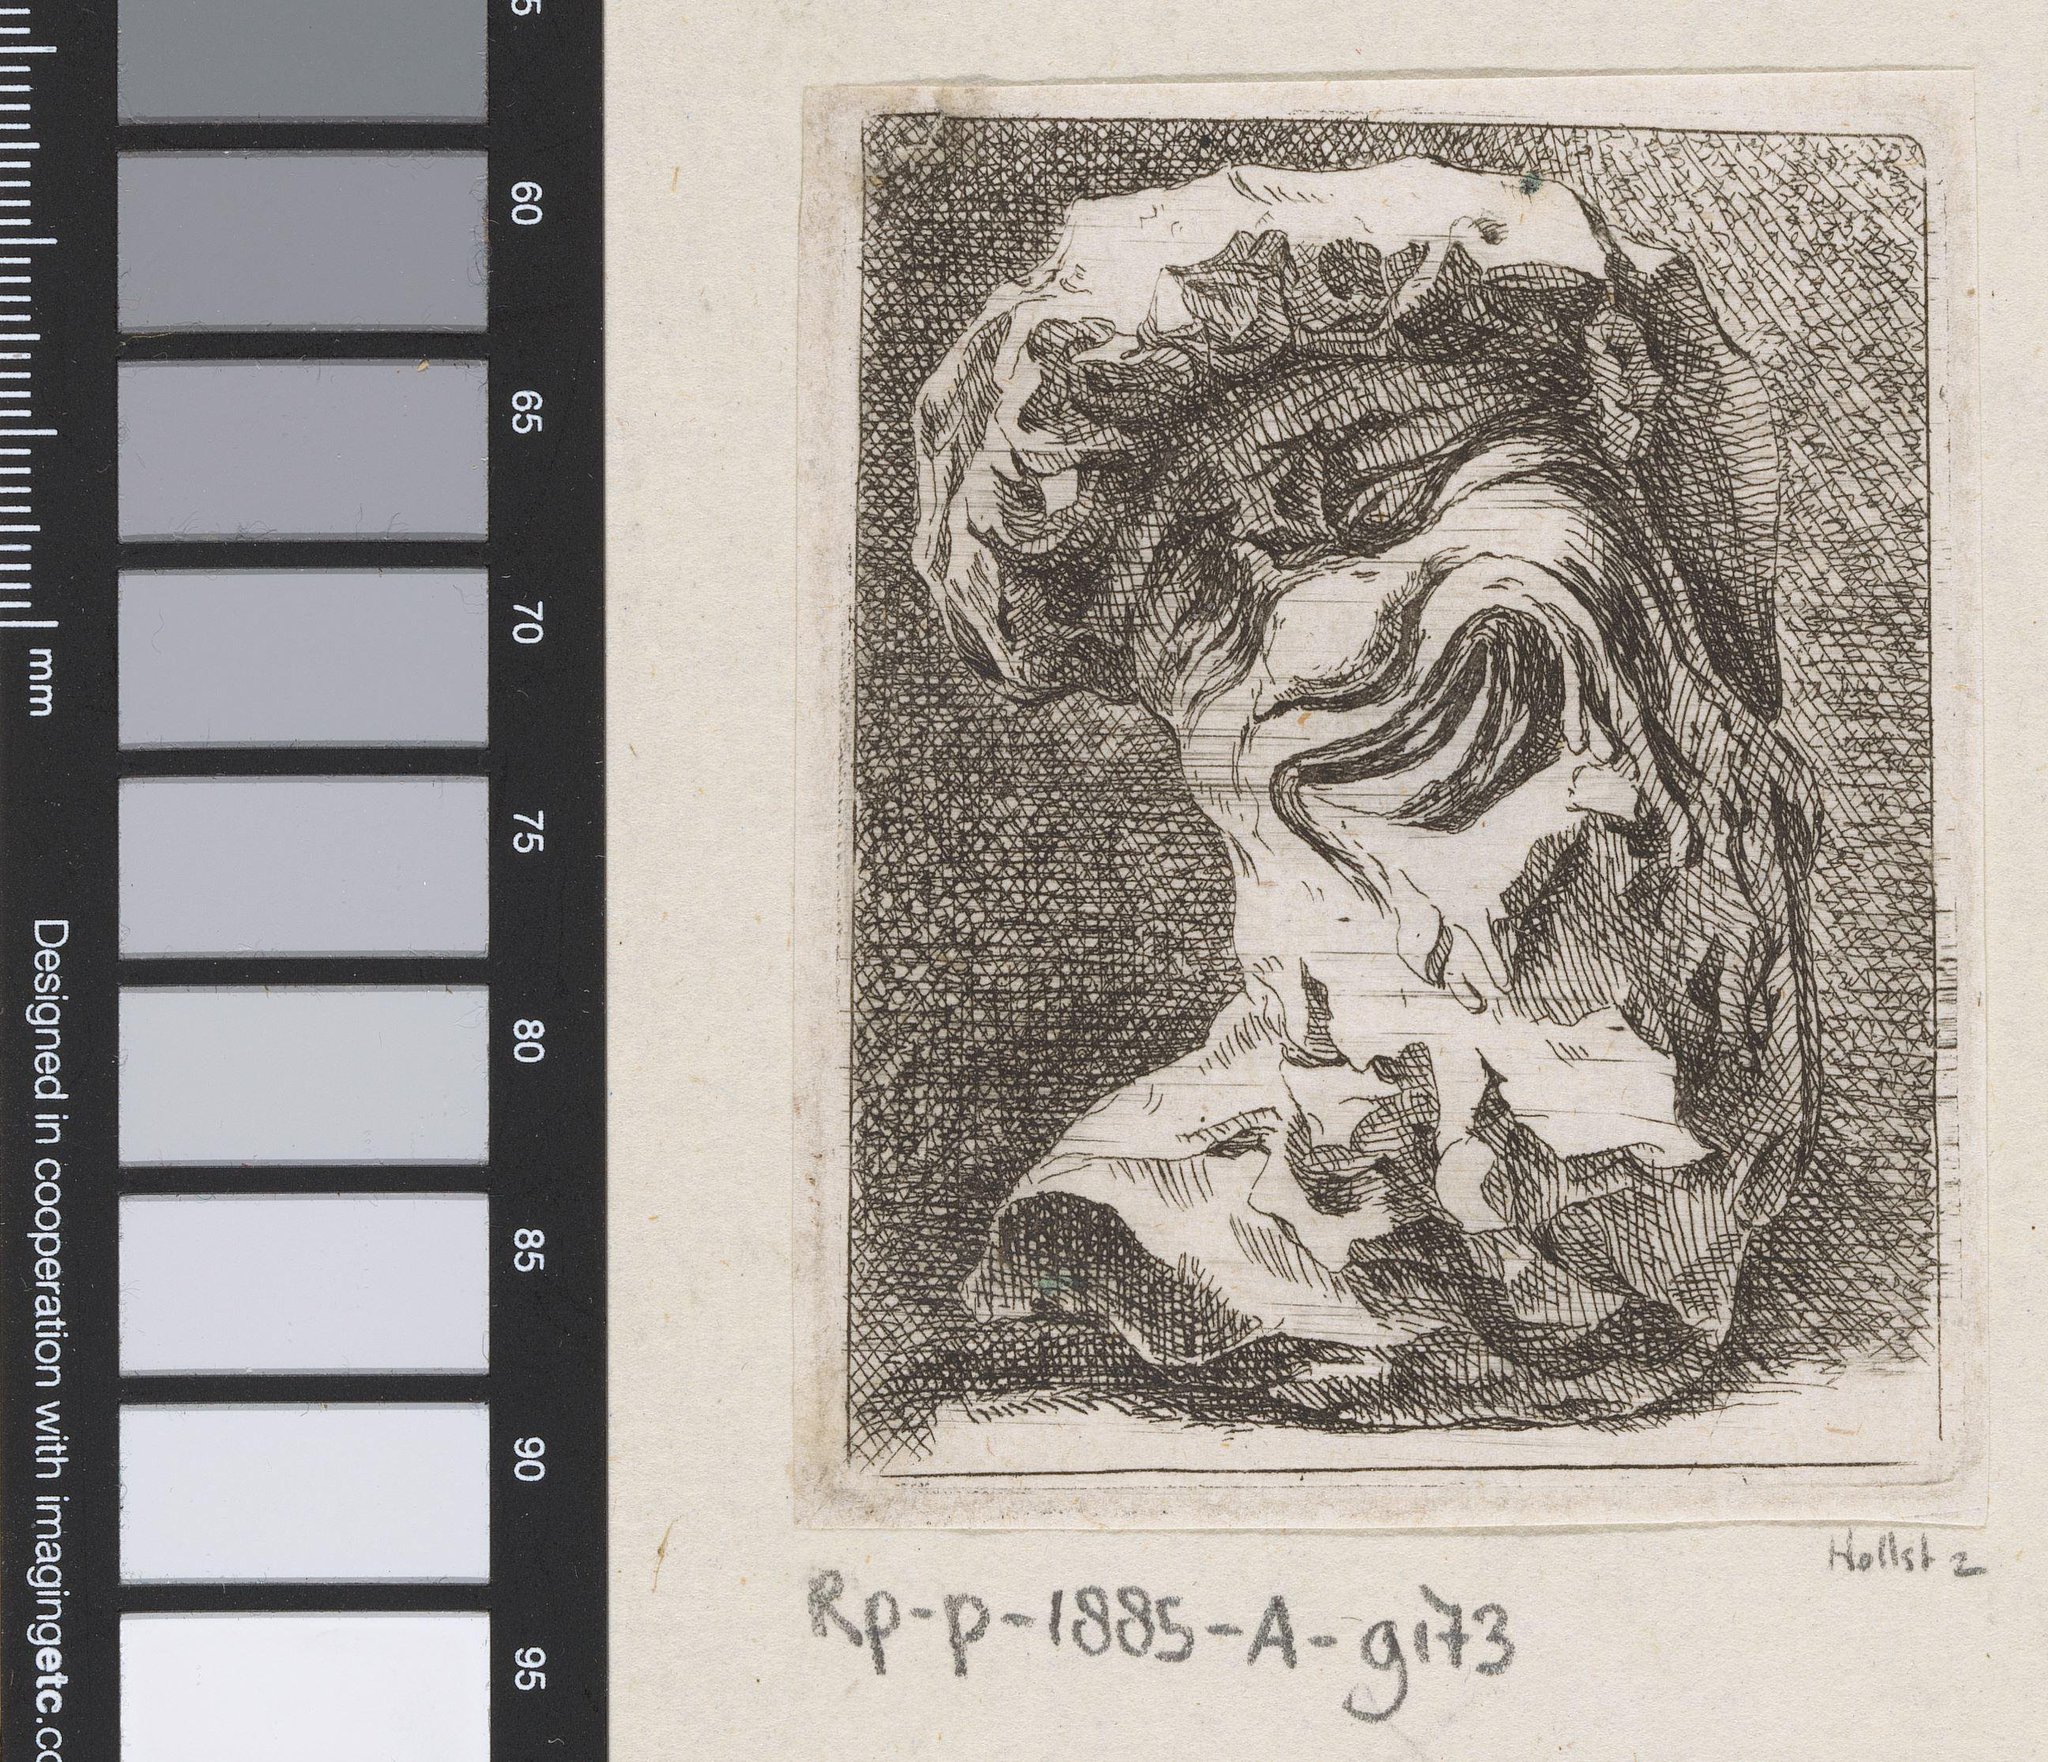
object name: print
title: Sculptuur van een groteske kop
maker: johann franz ermels (der ältere)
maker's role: draughtsman, print maker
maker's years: 1641-1693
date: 1651-1693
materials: paper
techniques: etching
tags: head (human), ugliness, piece of sculpture, reproduction of a piece of sculpture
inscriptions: collector's mark: Lugt 2228